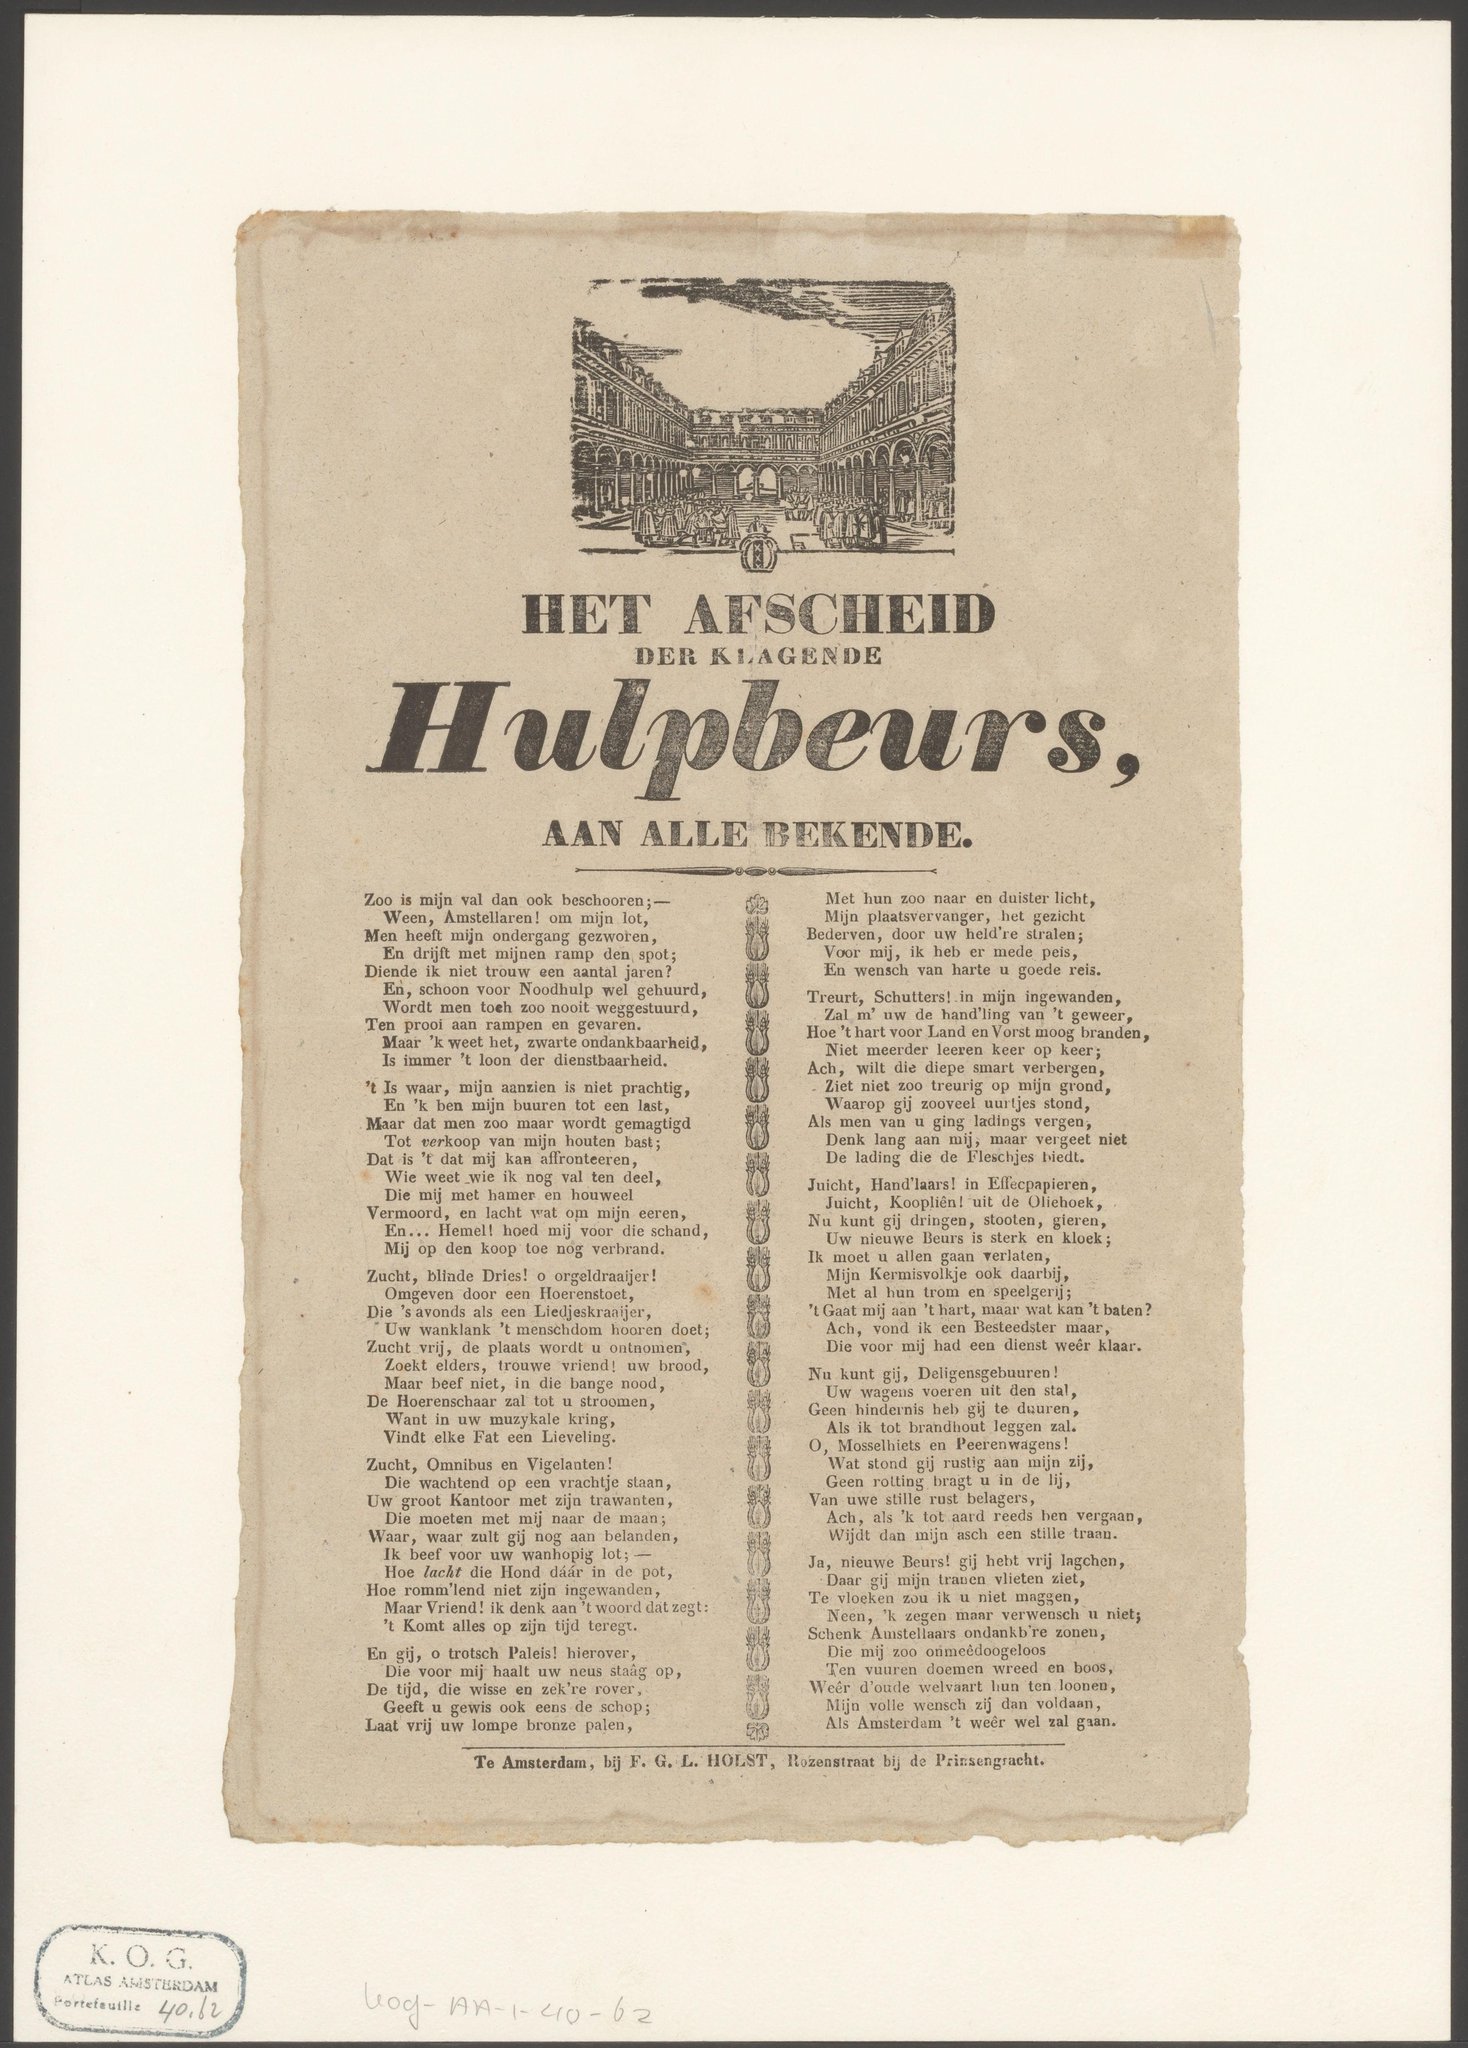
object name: text sheet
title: Het afscheid der klagende Hulpbeurs, aan alle bekende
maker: fredrik george lodewijk holst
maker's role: printer, publisher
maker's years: 1803-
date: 1845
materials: paper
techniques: letterpress printing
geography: amsterdam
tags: stock exchange, stock-market, demolition of building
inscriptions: collector's mark: Lugt 1641b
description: Onderwerpsrubriek binnen de Atlas Amsterdam: Handel en Zeevaart: Hulpbeurs op de Dam en Beurs (Dam).